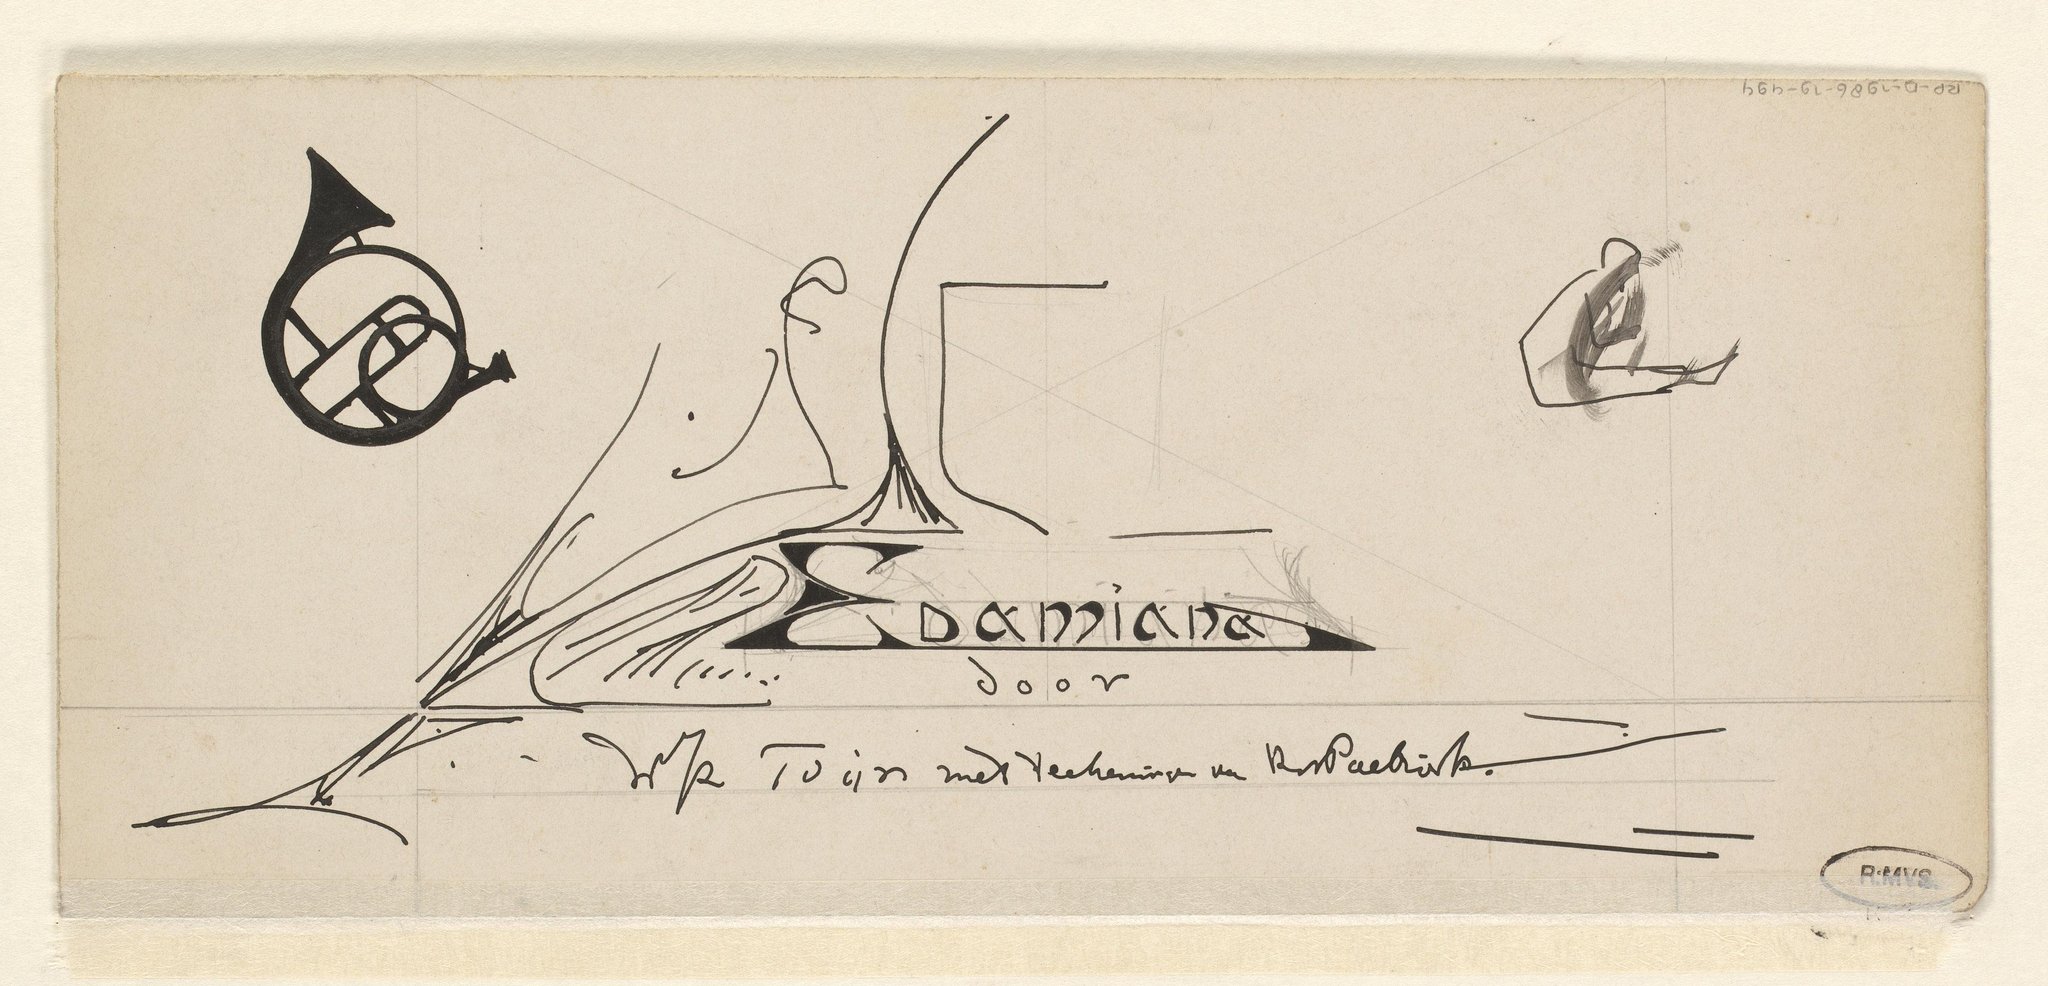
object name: drawing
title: Ontwerp voor een titelhoofd van Edamiana van W.J. Tuyn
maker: reinier willem petrus de vries (1874-1953)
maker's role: draughtsman, print maker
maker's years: 1874-1953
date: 1898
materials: ink, paper, pencil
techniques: brush, pen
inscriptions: collector's mark: ‘R:MVS.’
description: Ontwerp voor een titelhoofd van: Tuyn, W.J. Edamiana, in: Woord en Beeld. Geïllustreerd maandschrift, mei 1898.